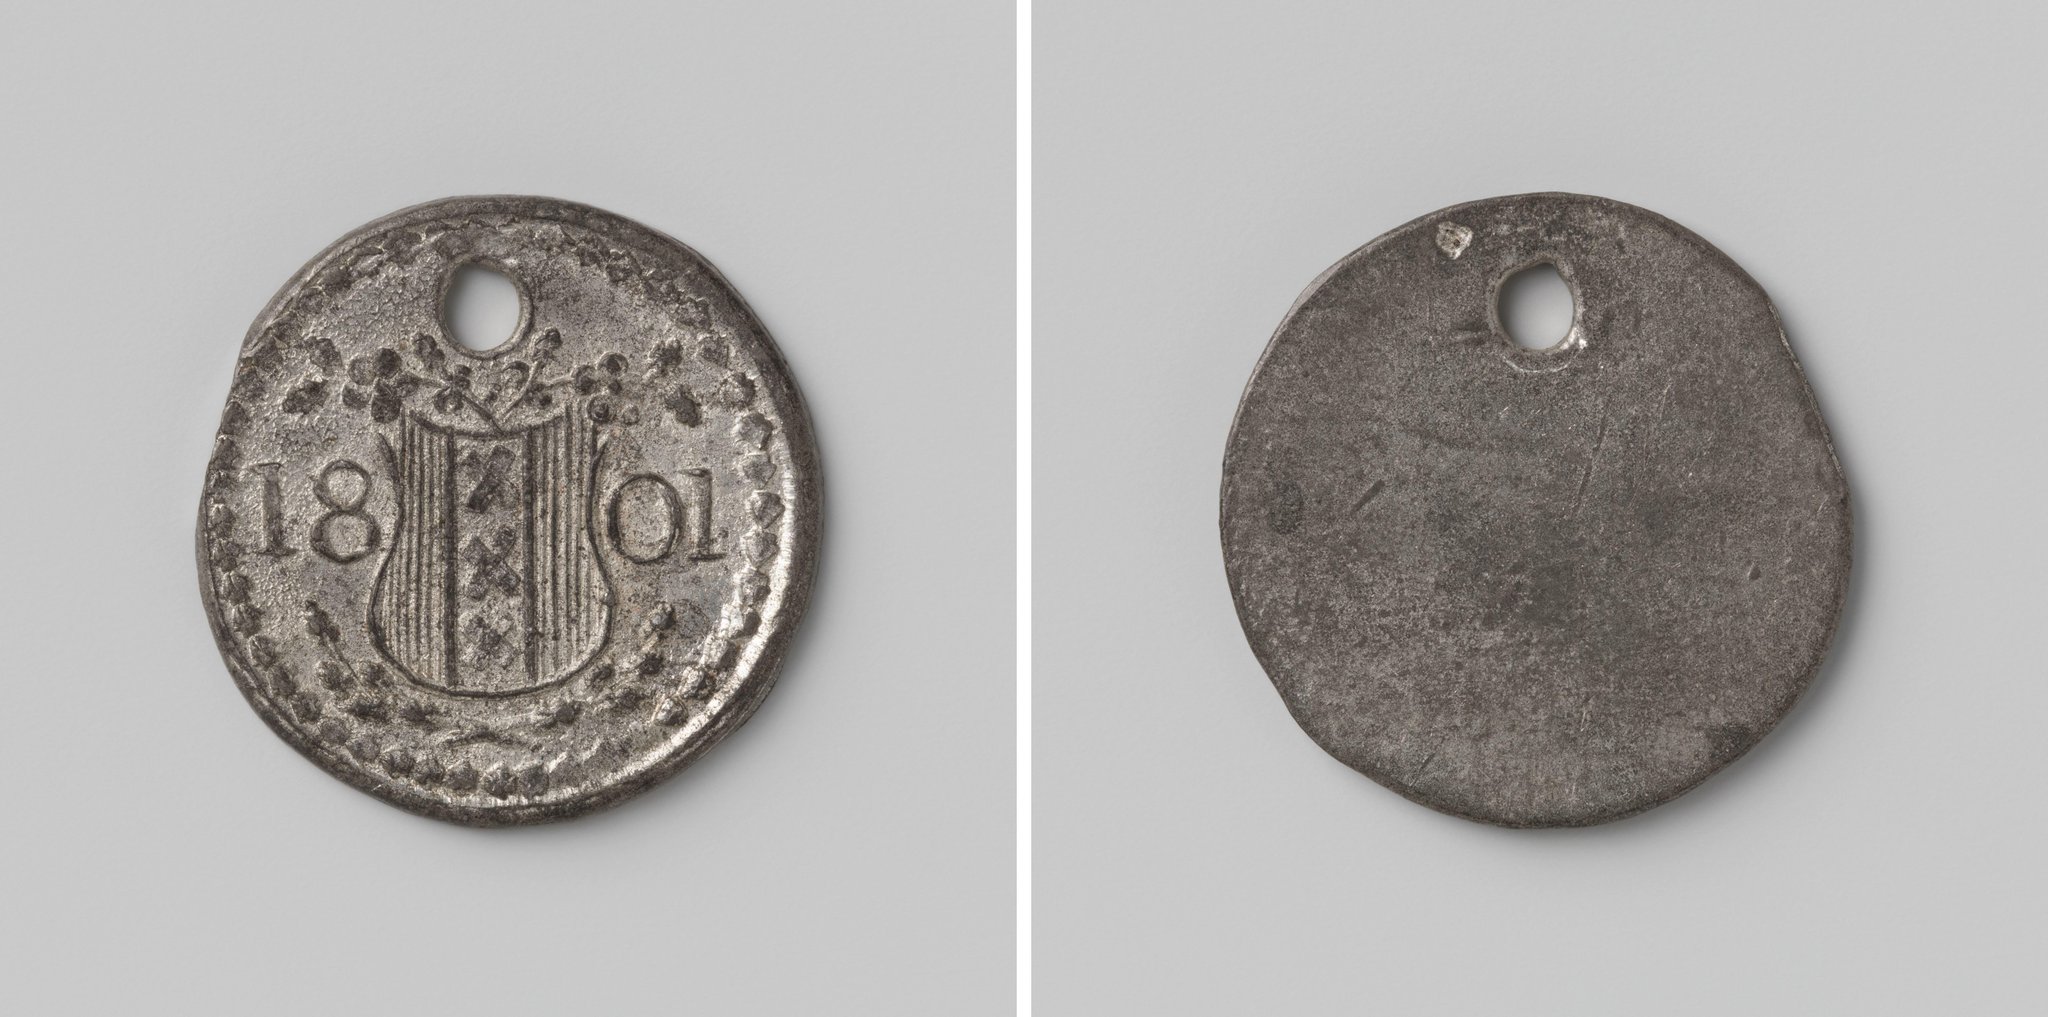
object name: hondenbelastingloodje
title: Aalmoezeniersweeshuis te Amsterdam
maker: Anonymous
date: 1801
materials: tin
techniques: striking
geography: amsterdam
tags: amsterdam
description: eenzijdig loodje met gat erin. Voorzijde: wapenschild op twee gekruiste bladertakken tussen jaartal. Keerzijde: blanco